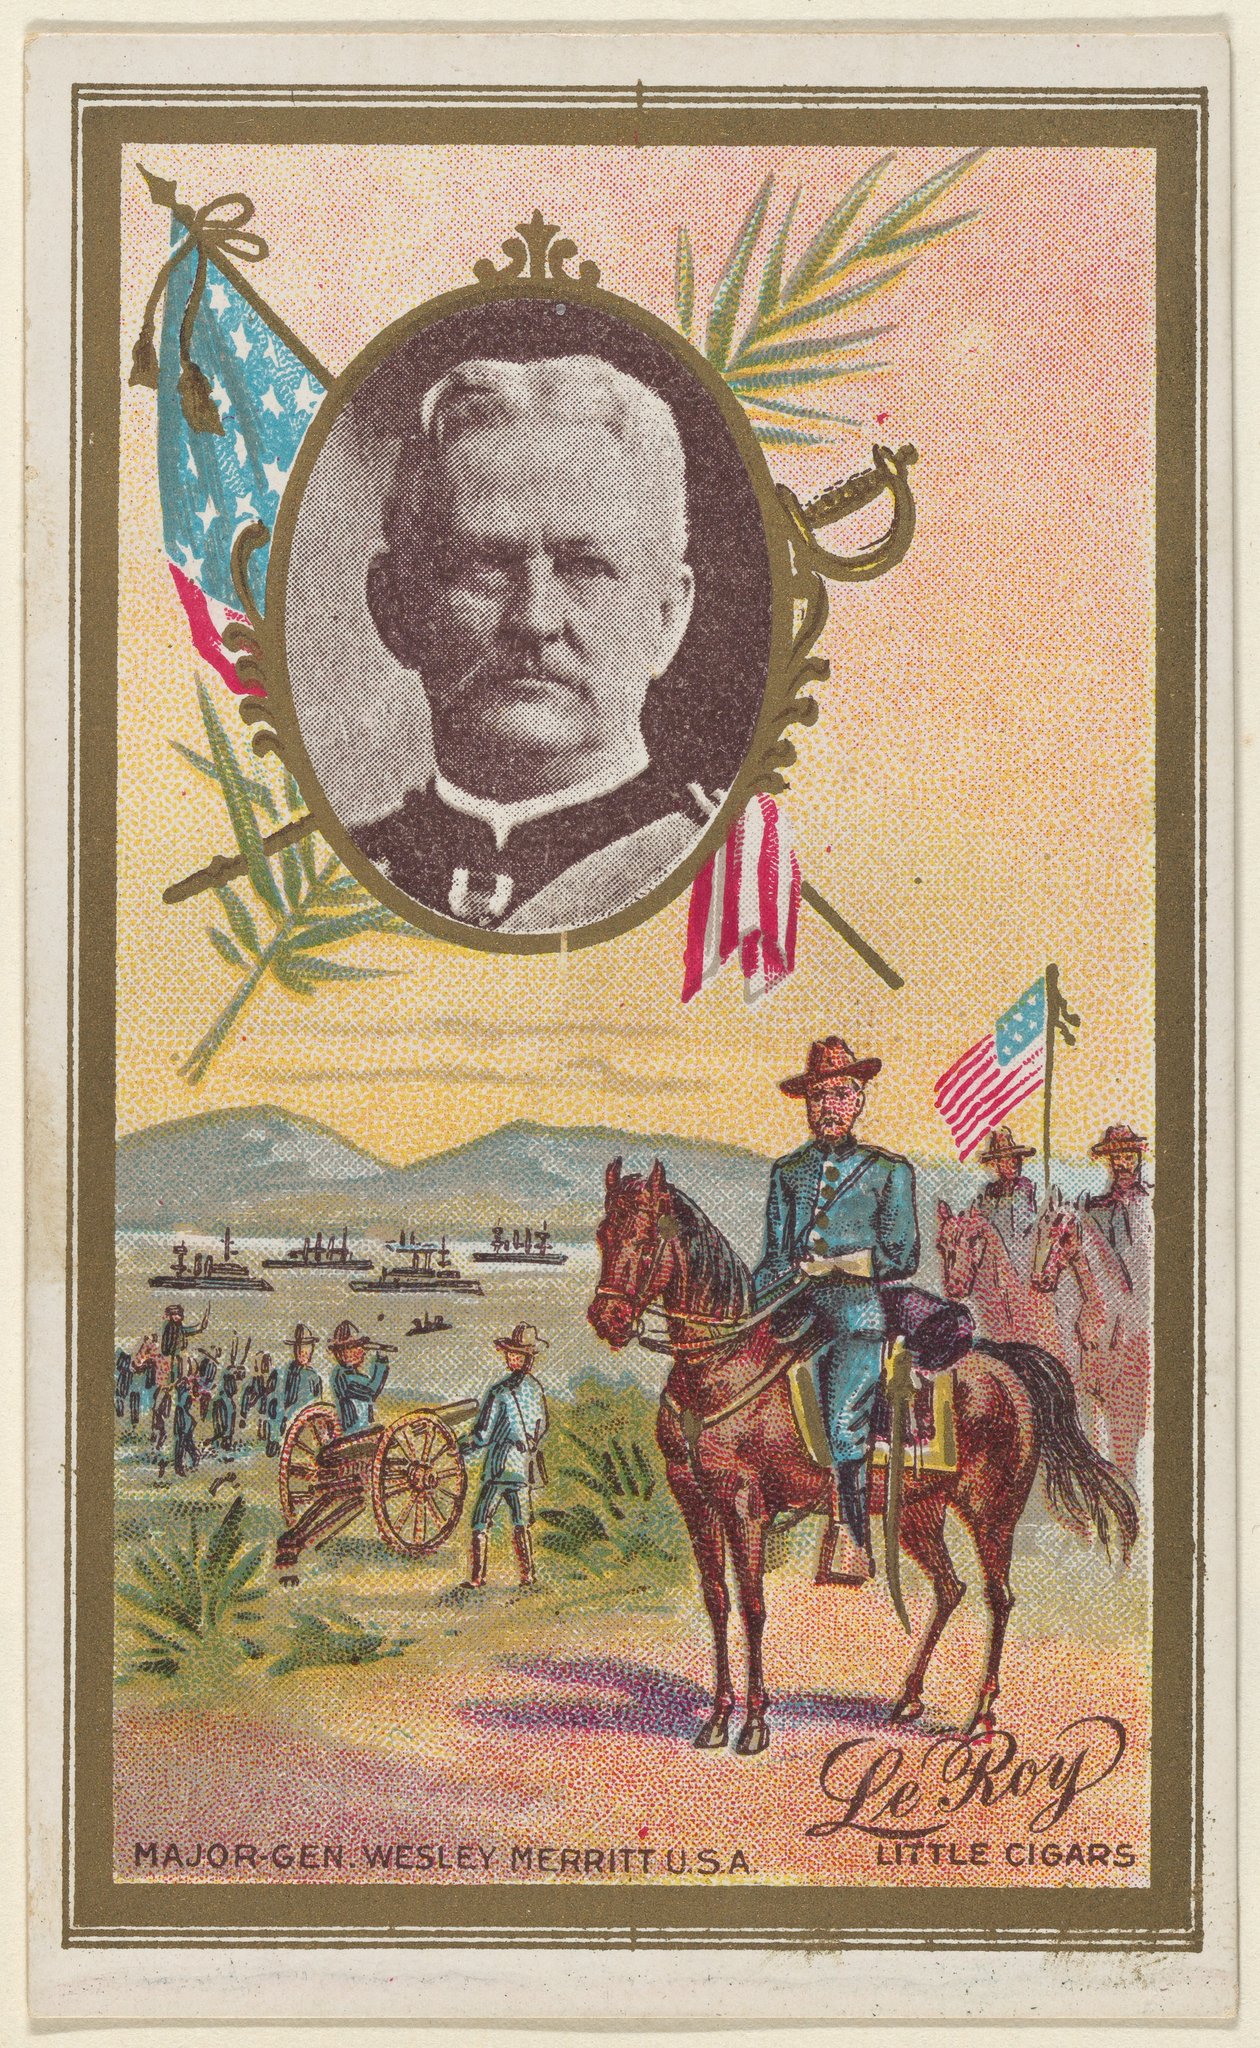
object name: print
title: Major General Wesley Merritt, U.S. Army, from the "Generals" series (T63), issued by LeRoy Little Cigars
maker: leroy little cigars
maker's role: publisher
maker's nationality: american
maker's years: 1850-1950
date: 1898-1901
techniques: color lithograph